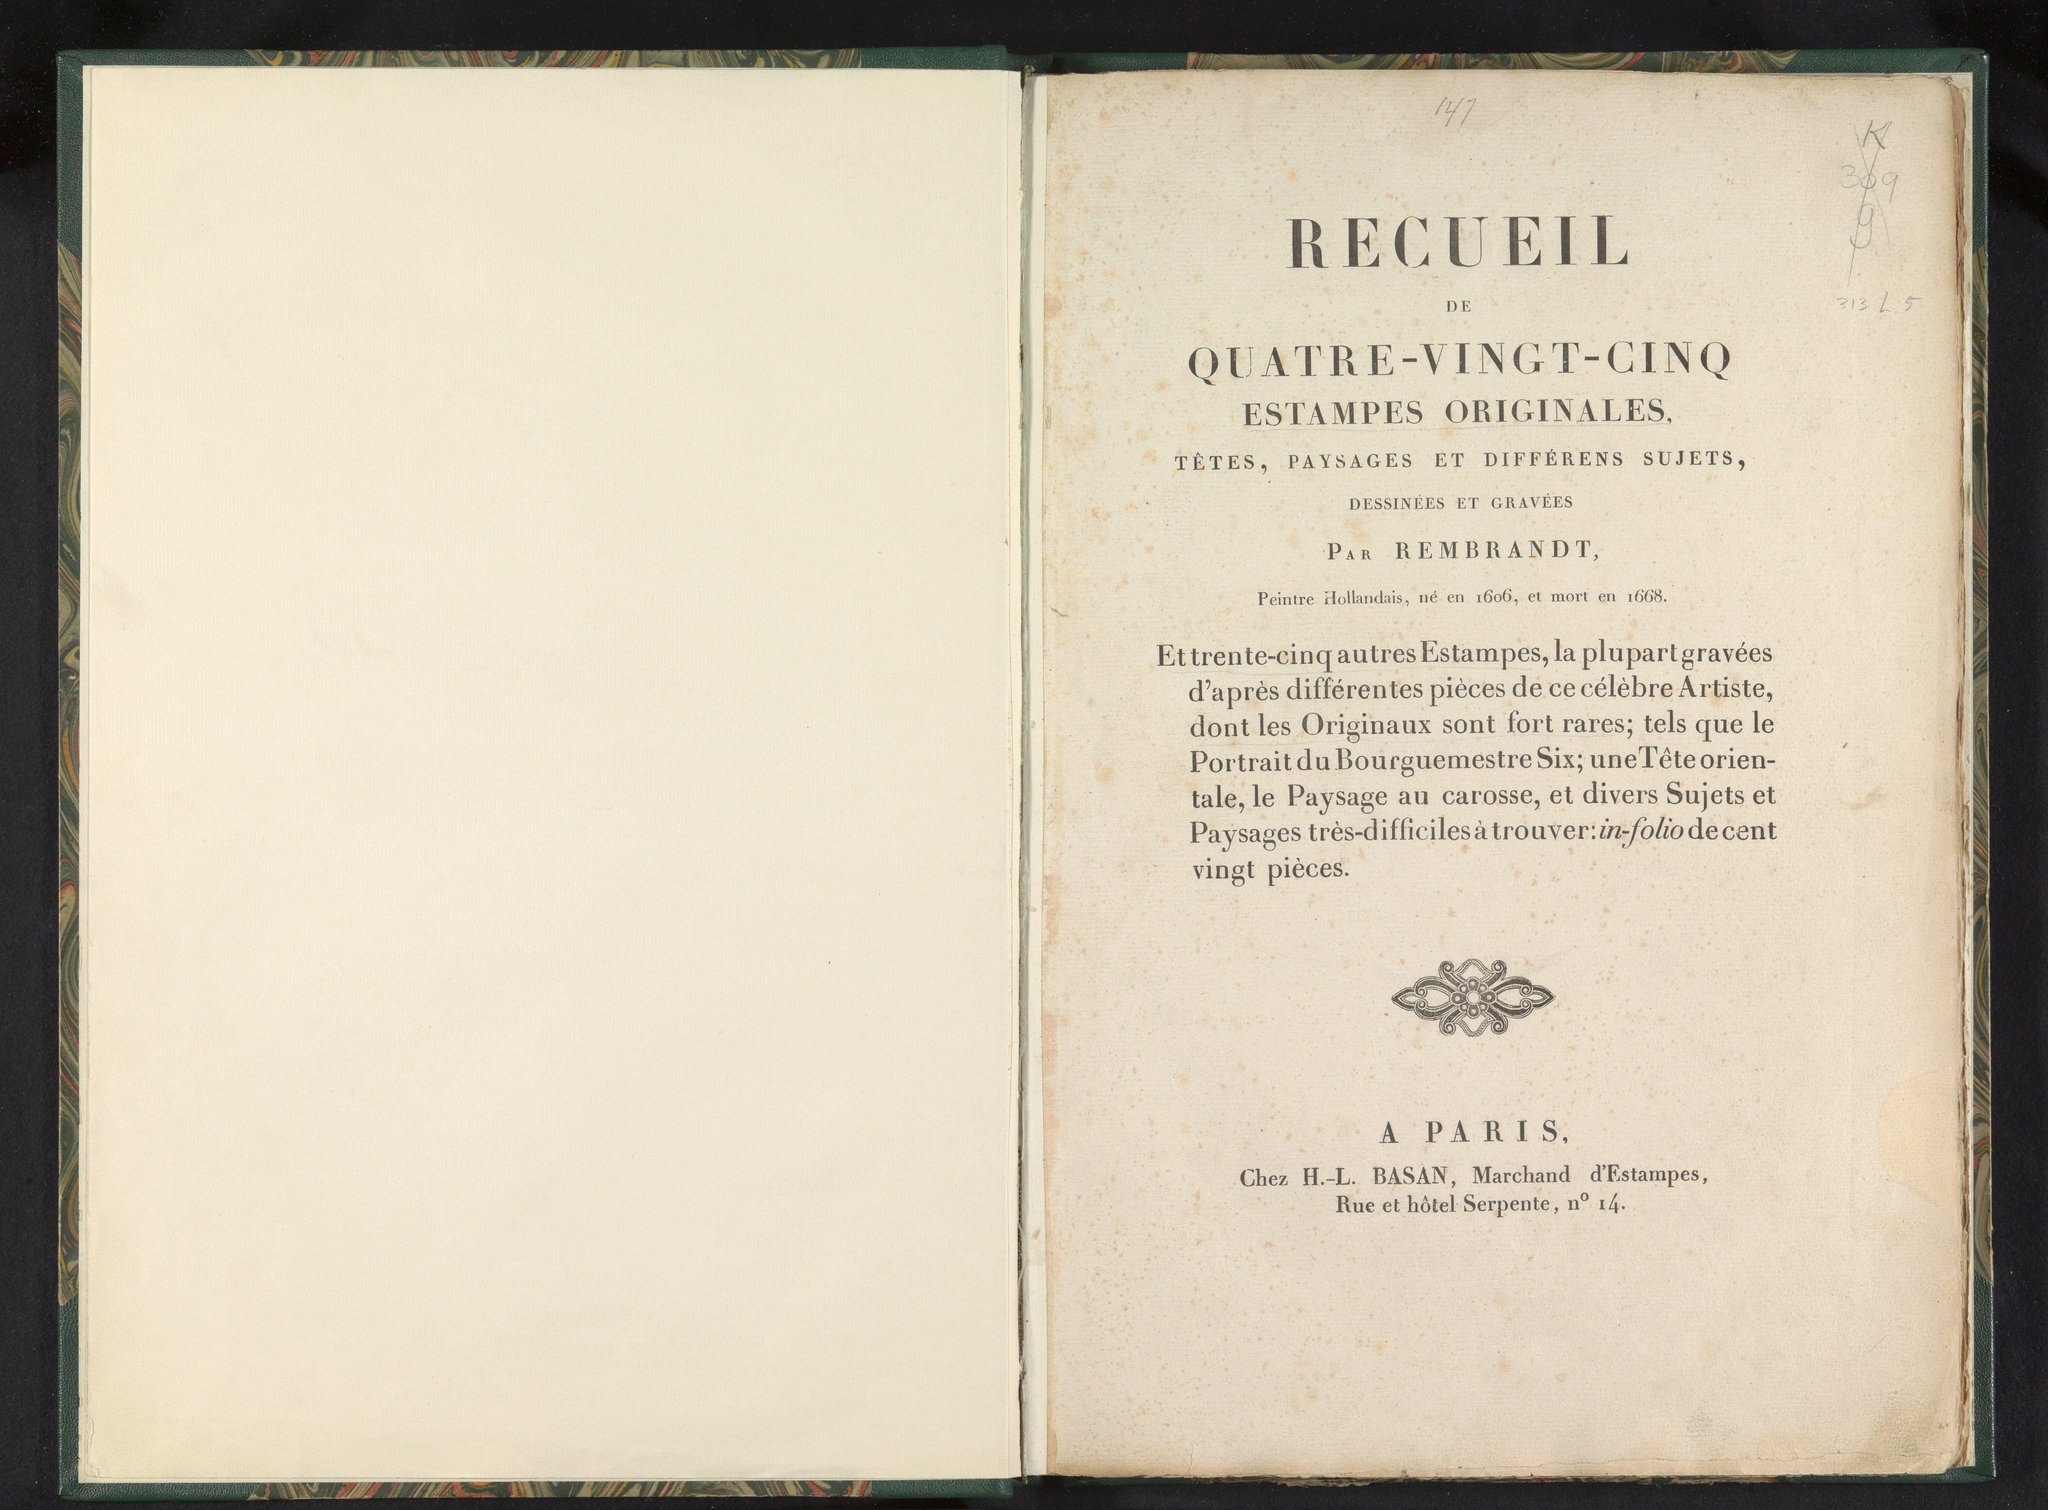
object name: album leaf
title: Recueil de quatre-vingt-cinq estampes originales, tetes, paysages et différens sujets, dessinées et gravées par Rembrandt. A Paris, Chez H.L. Basan [1807-1808]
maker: henry louis basan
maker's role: printer, publisher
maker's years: -1819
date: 1807-1808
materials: paper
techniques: letterpress printing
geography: paris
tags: title-page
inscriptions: collector's mark: ‘B’, collector's mark: ‘RIJKS / MUSM’